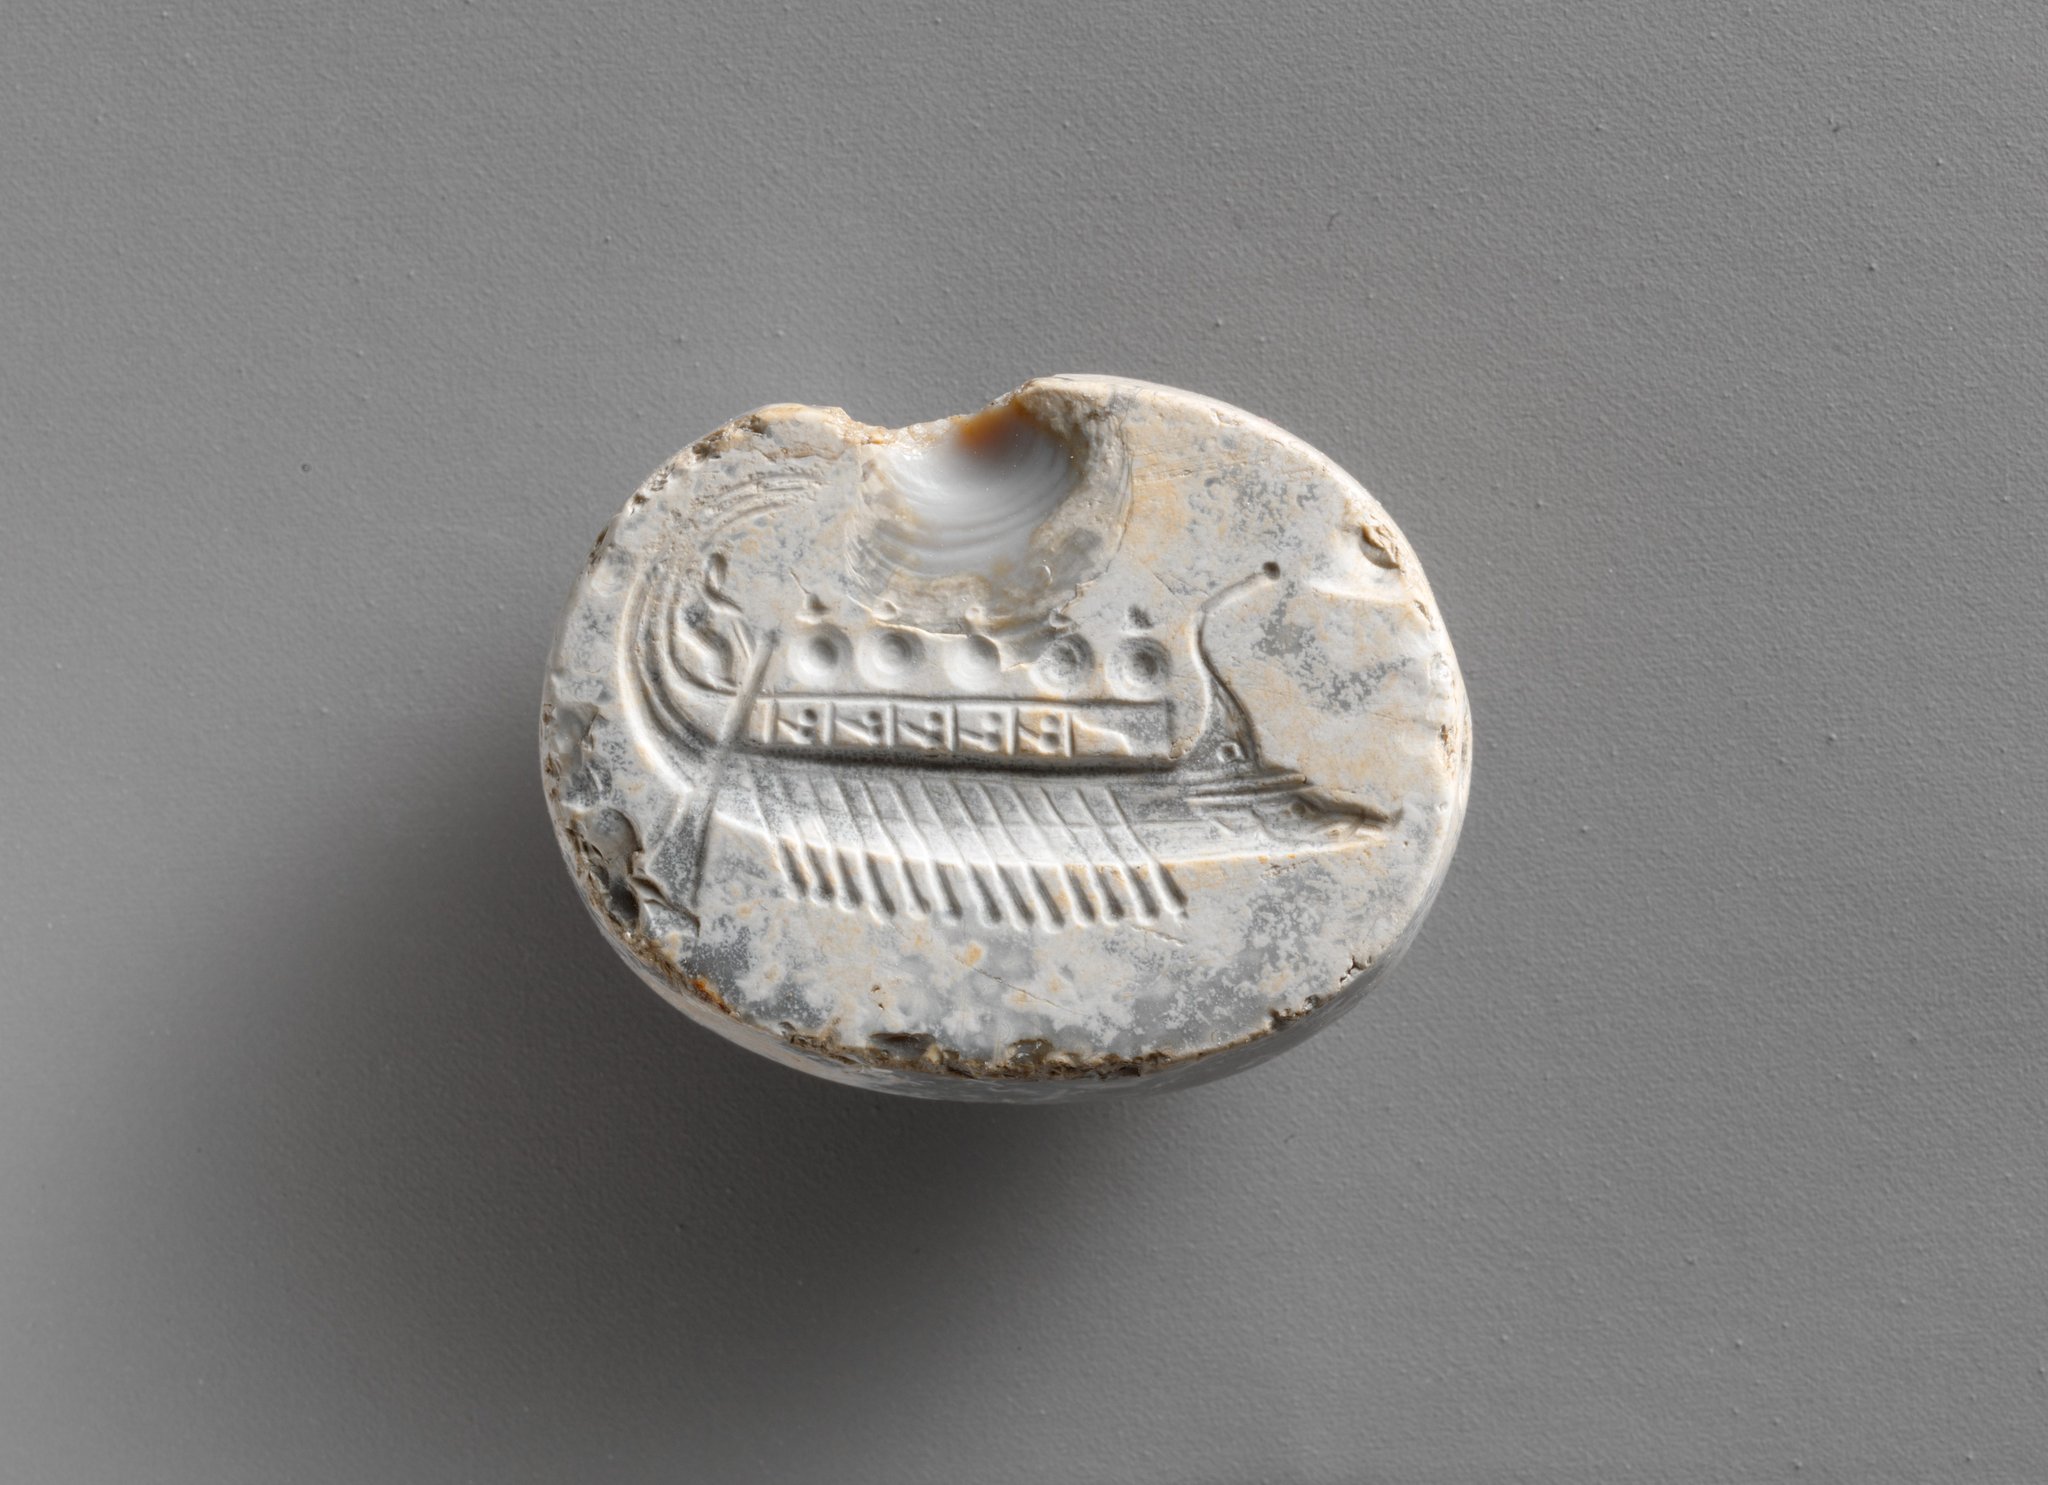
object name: scaraboid with ship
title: Chalcedony scaraboid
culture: greek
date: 525-500 BCE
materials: stone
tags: ships